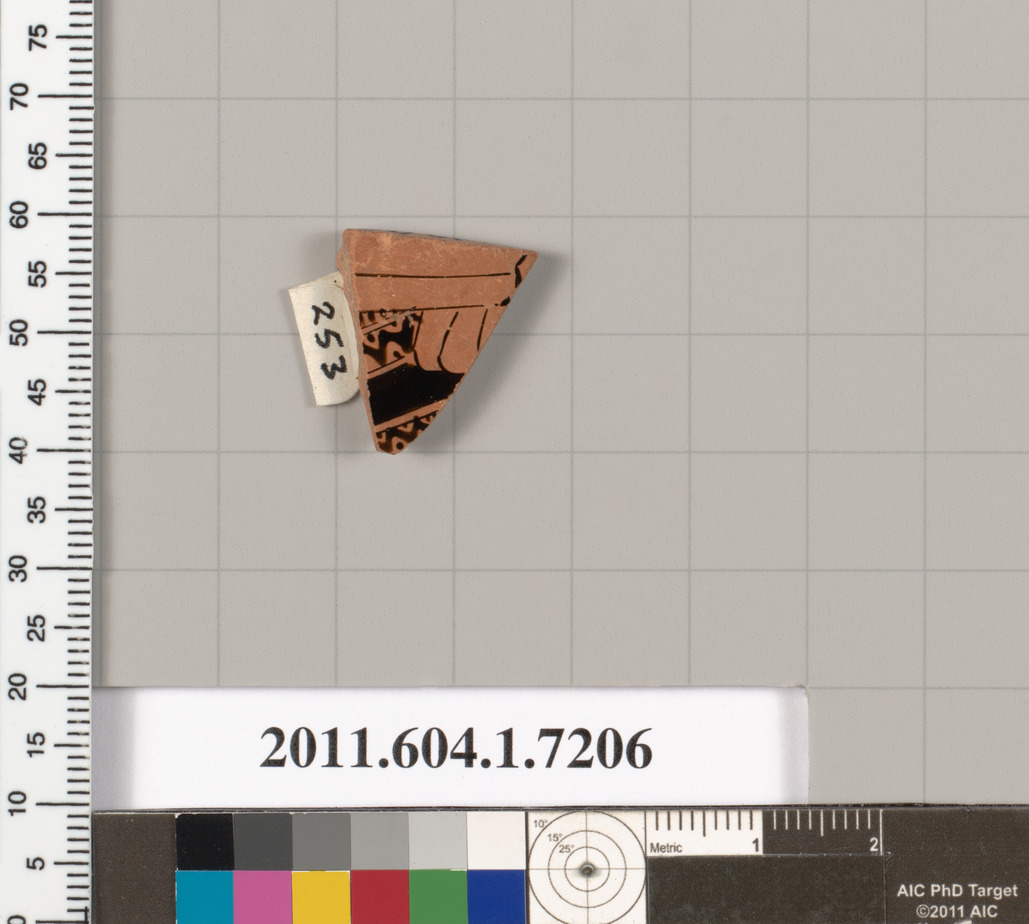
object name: kylix fragment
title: Terracotta fragment of a kylix (drinking cup)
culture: greek, attic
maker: makron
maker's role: artist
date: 500-480 BCE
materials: terracotta